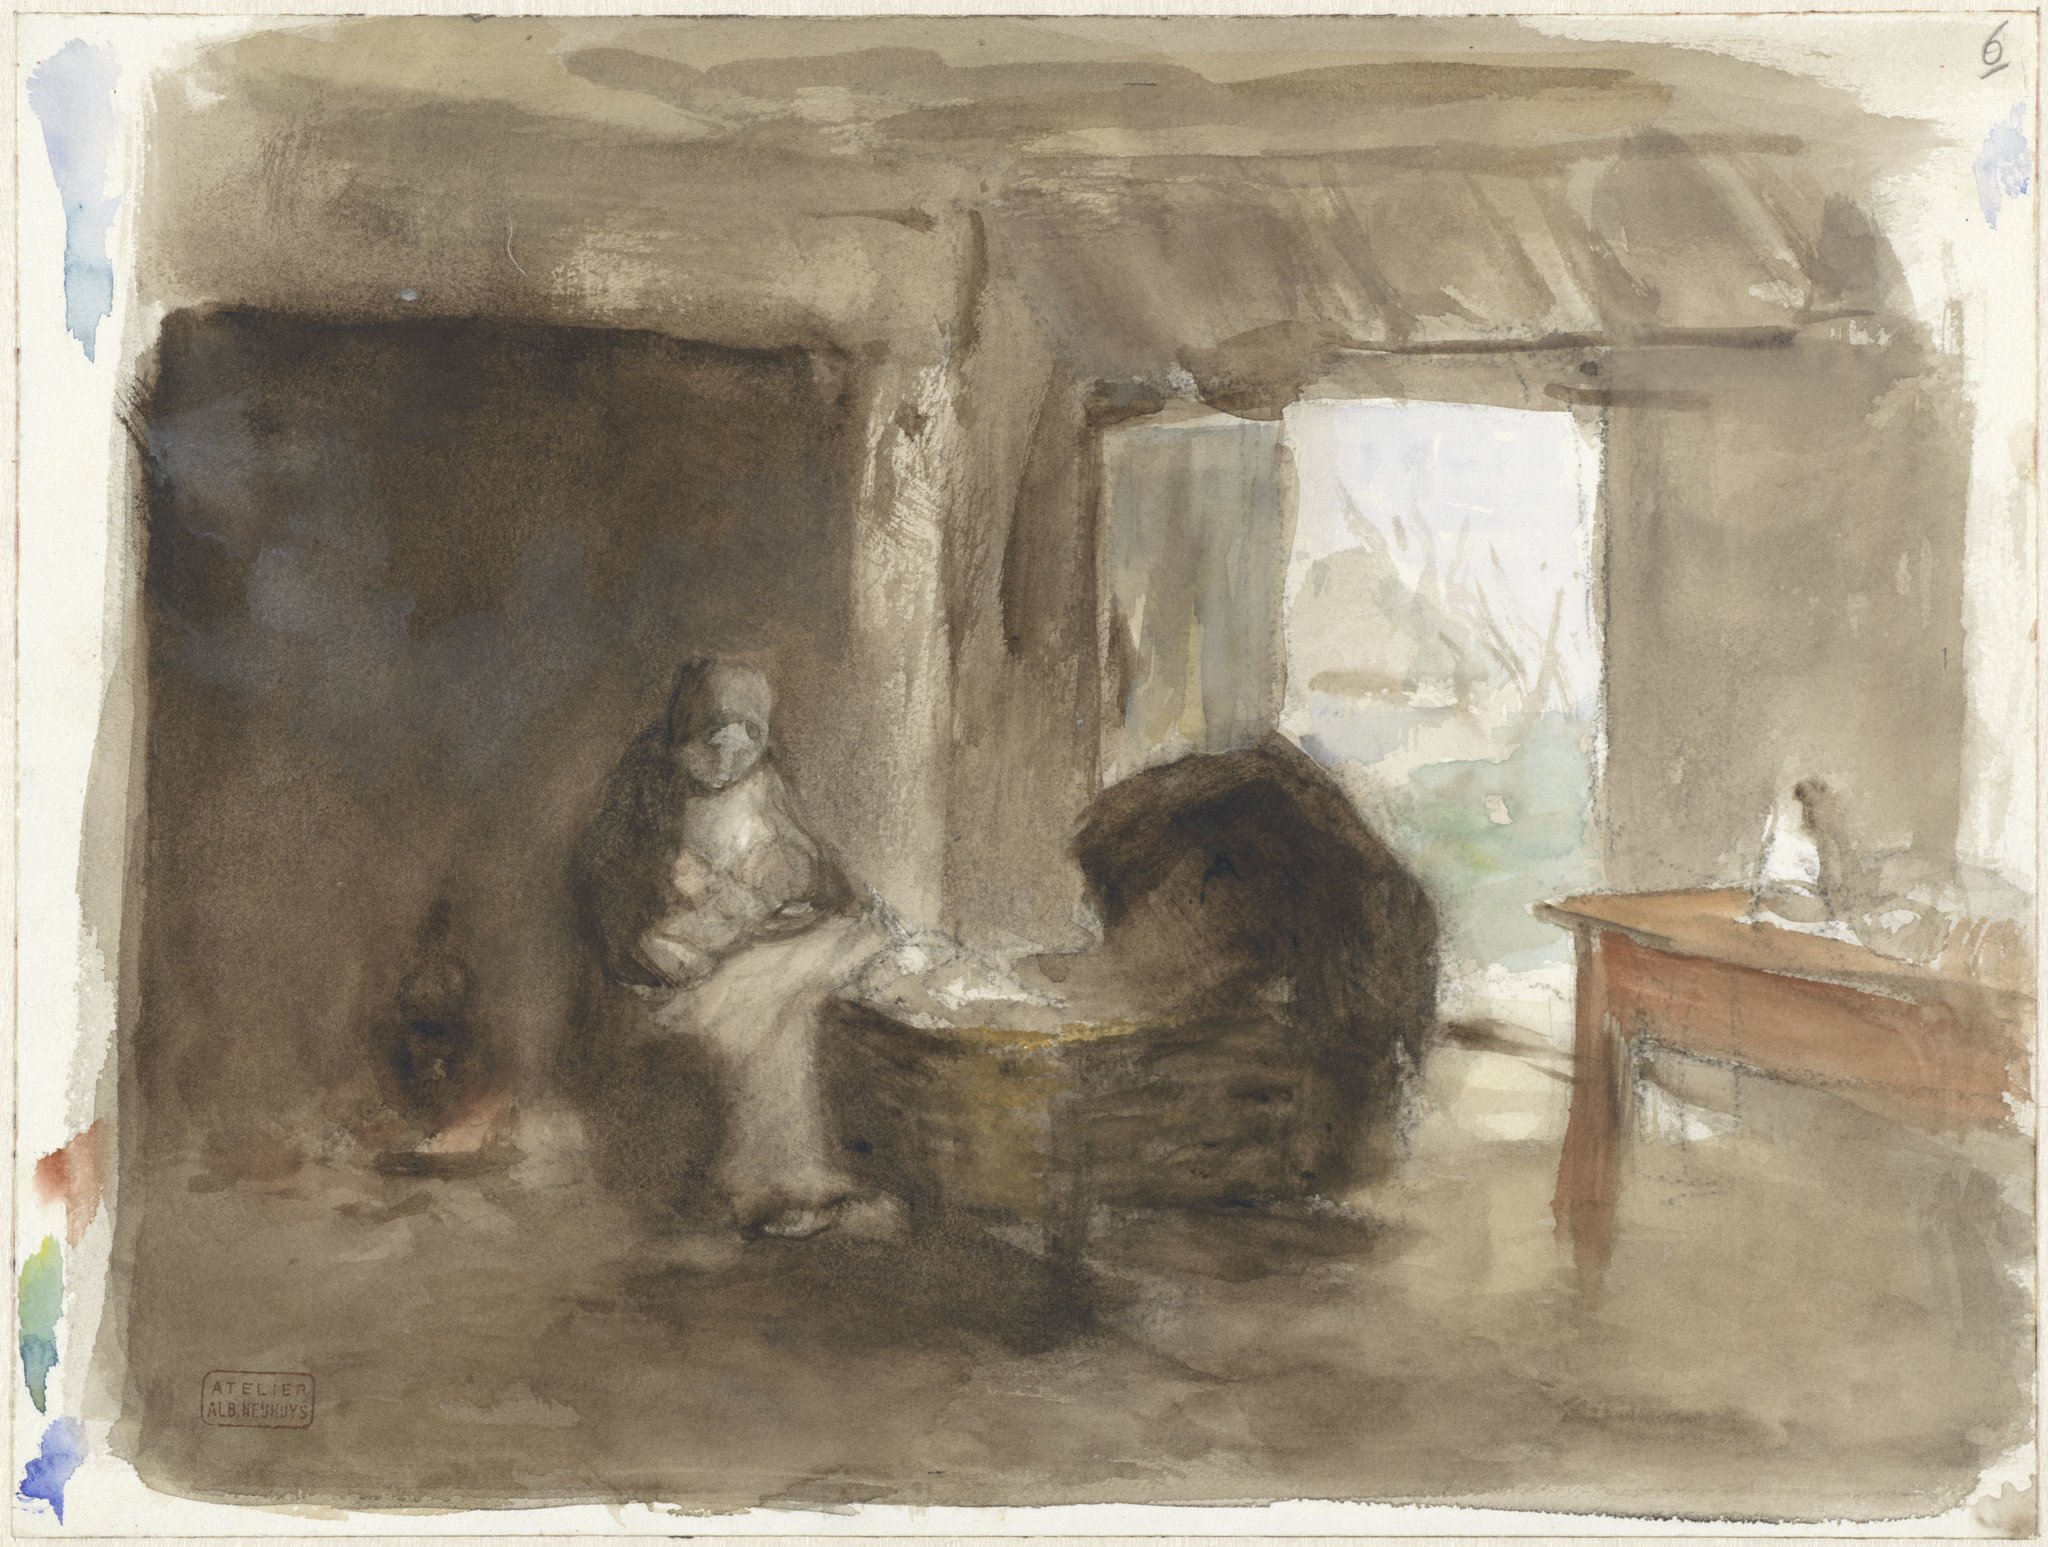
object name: drawing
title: Vrouw met kind bij een wieg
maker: albert neuhuys (1844-1914)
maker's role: draughtsman, painter, print maker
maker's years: 1844-1914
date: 1854-1914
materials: chalk, paper, watercolor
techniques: brush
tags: mother and baby or young child